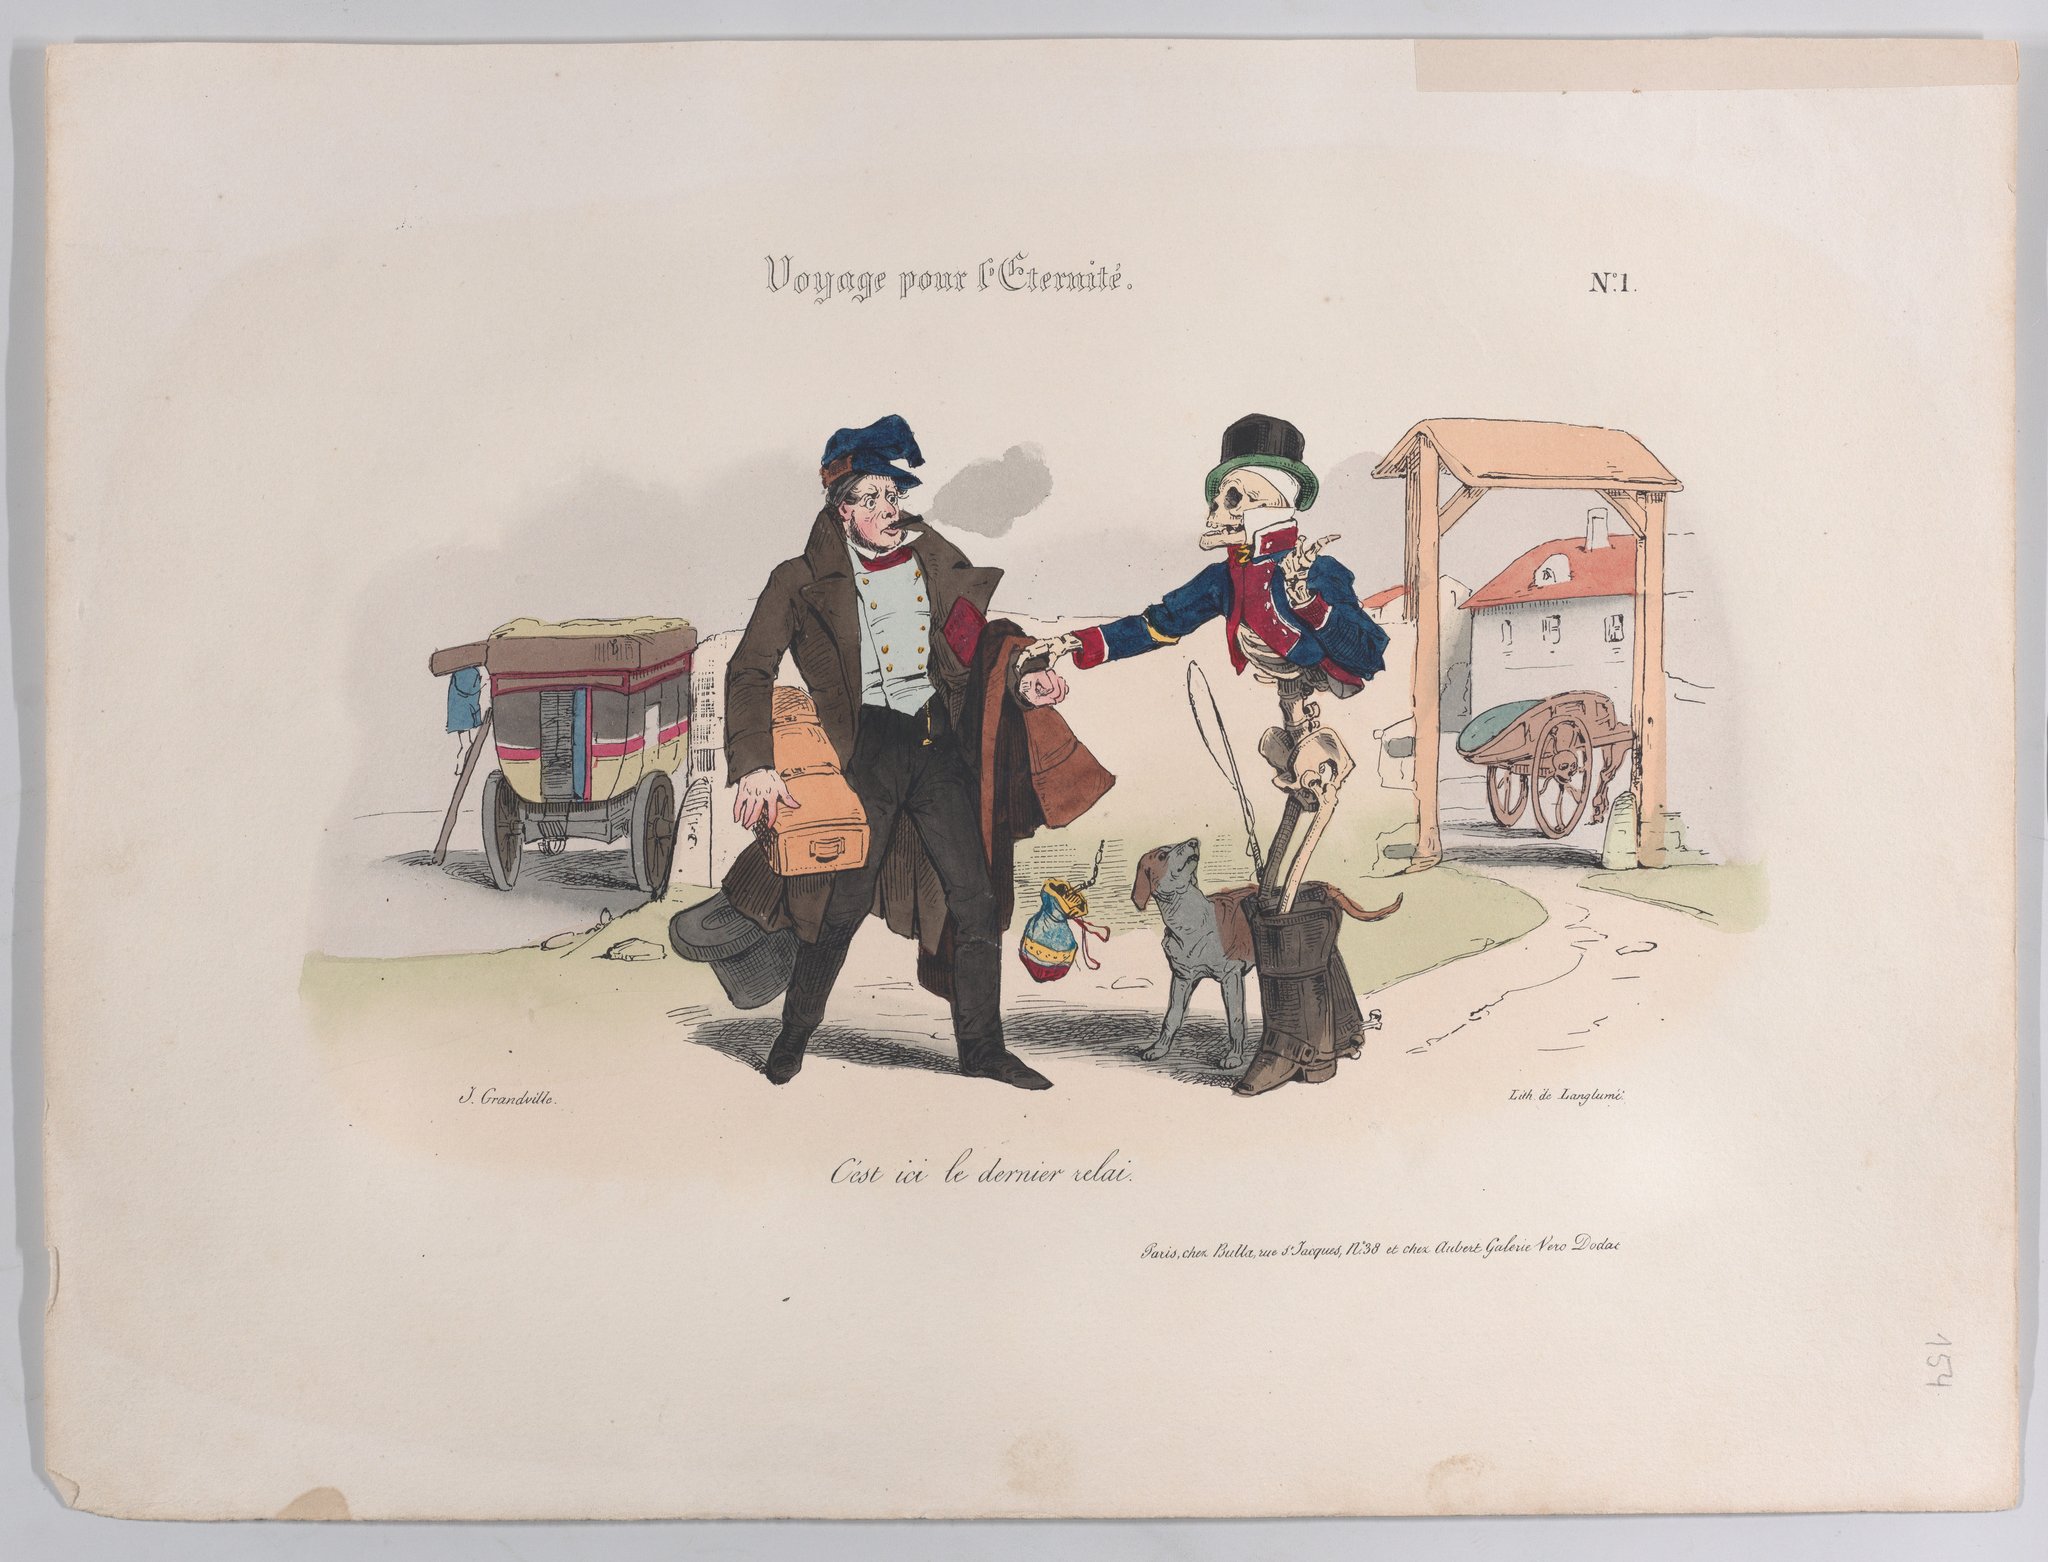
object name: print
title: Journey for Eternity, No. 3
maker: j. j. grandville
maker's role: designer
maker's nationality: french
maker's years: 1803-1847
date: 1839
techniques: lithograph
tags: skeletons,men,smoking,dogs